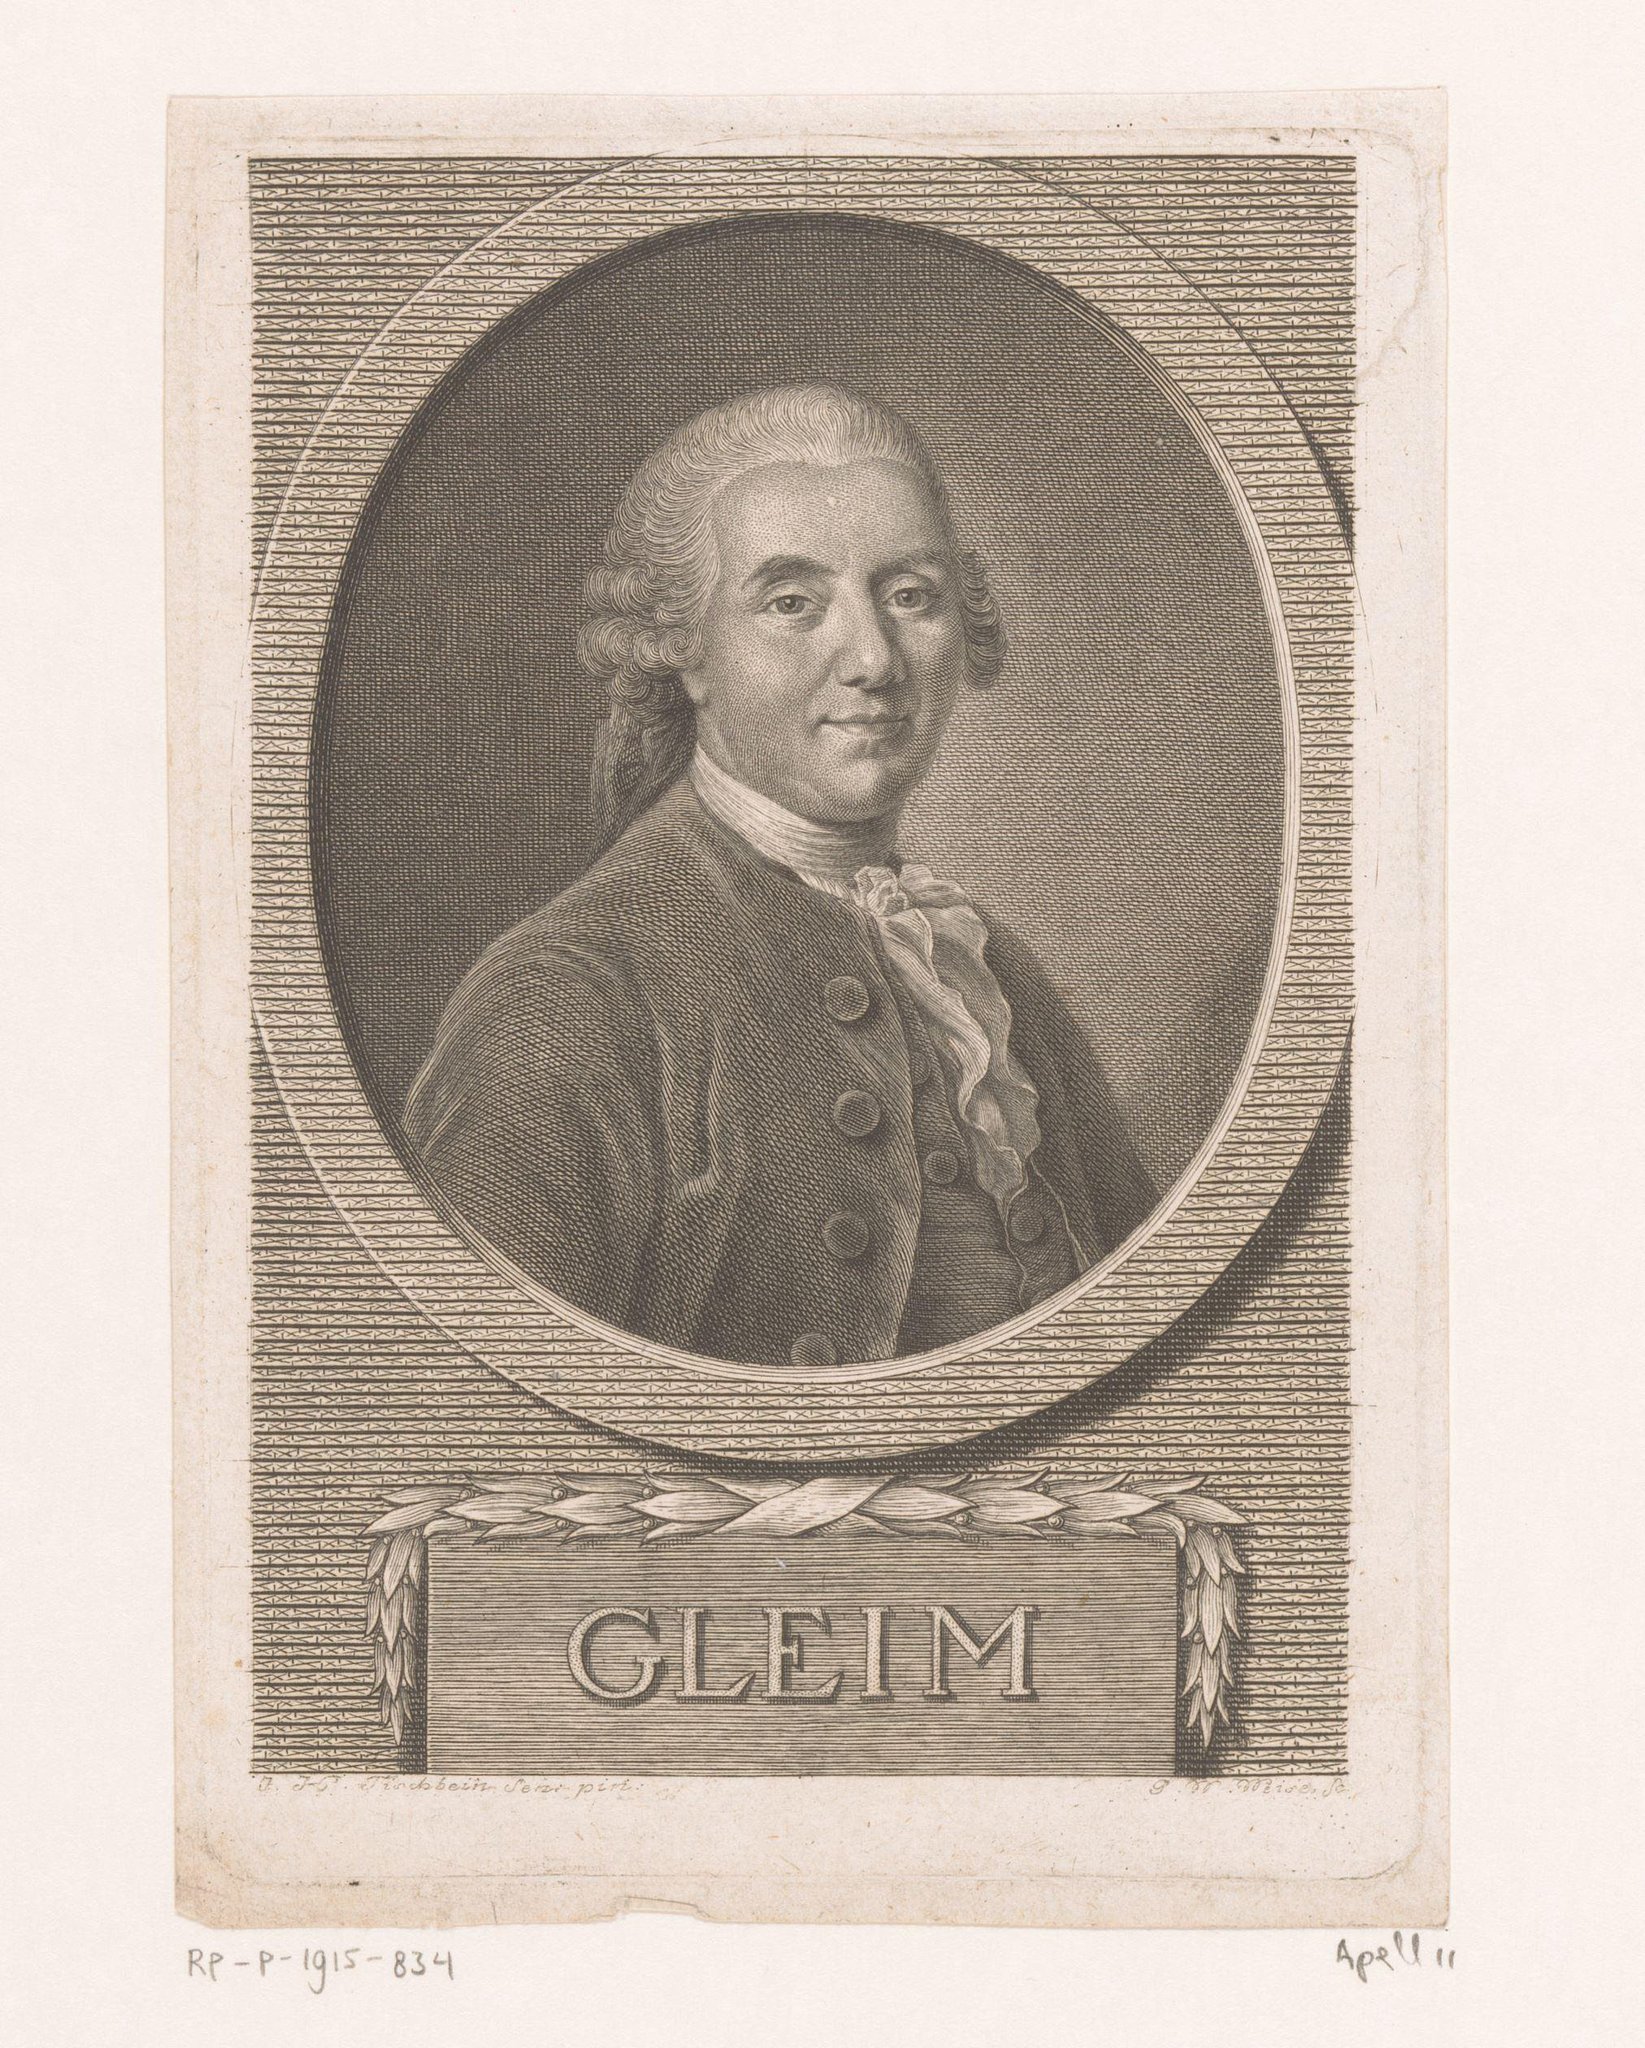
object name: print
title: Portret van Ludwig Gleim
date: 1761-1810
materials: paper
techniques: engraving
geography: germany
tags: historical persons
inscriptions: collector's mark: Lugt 2228